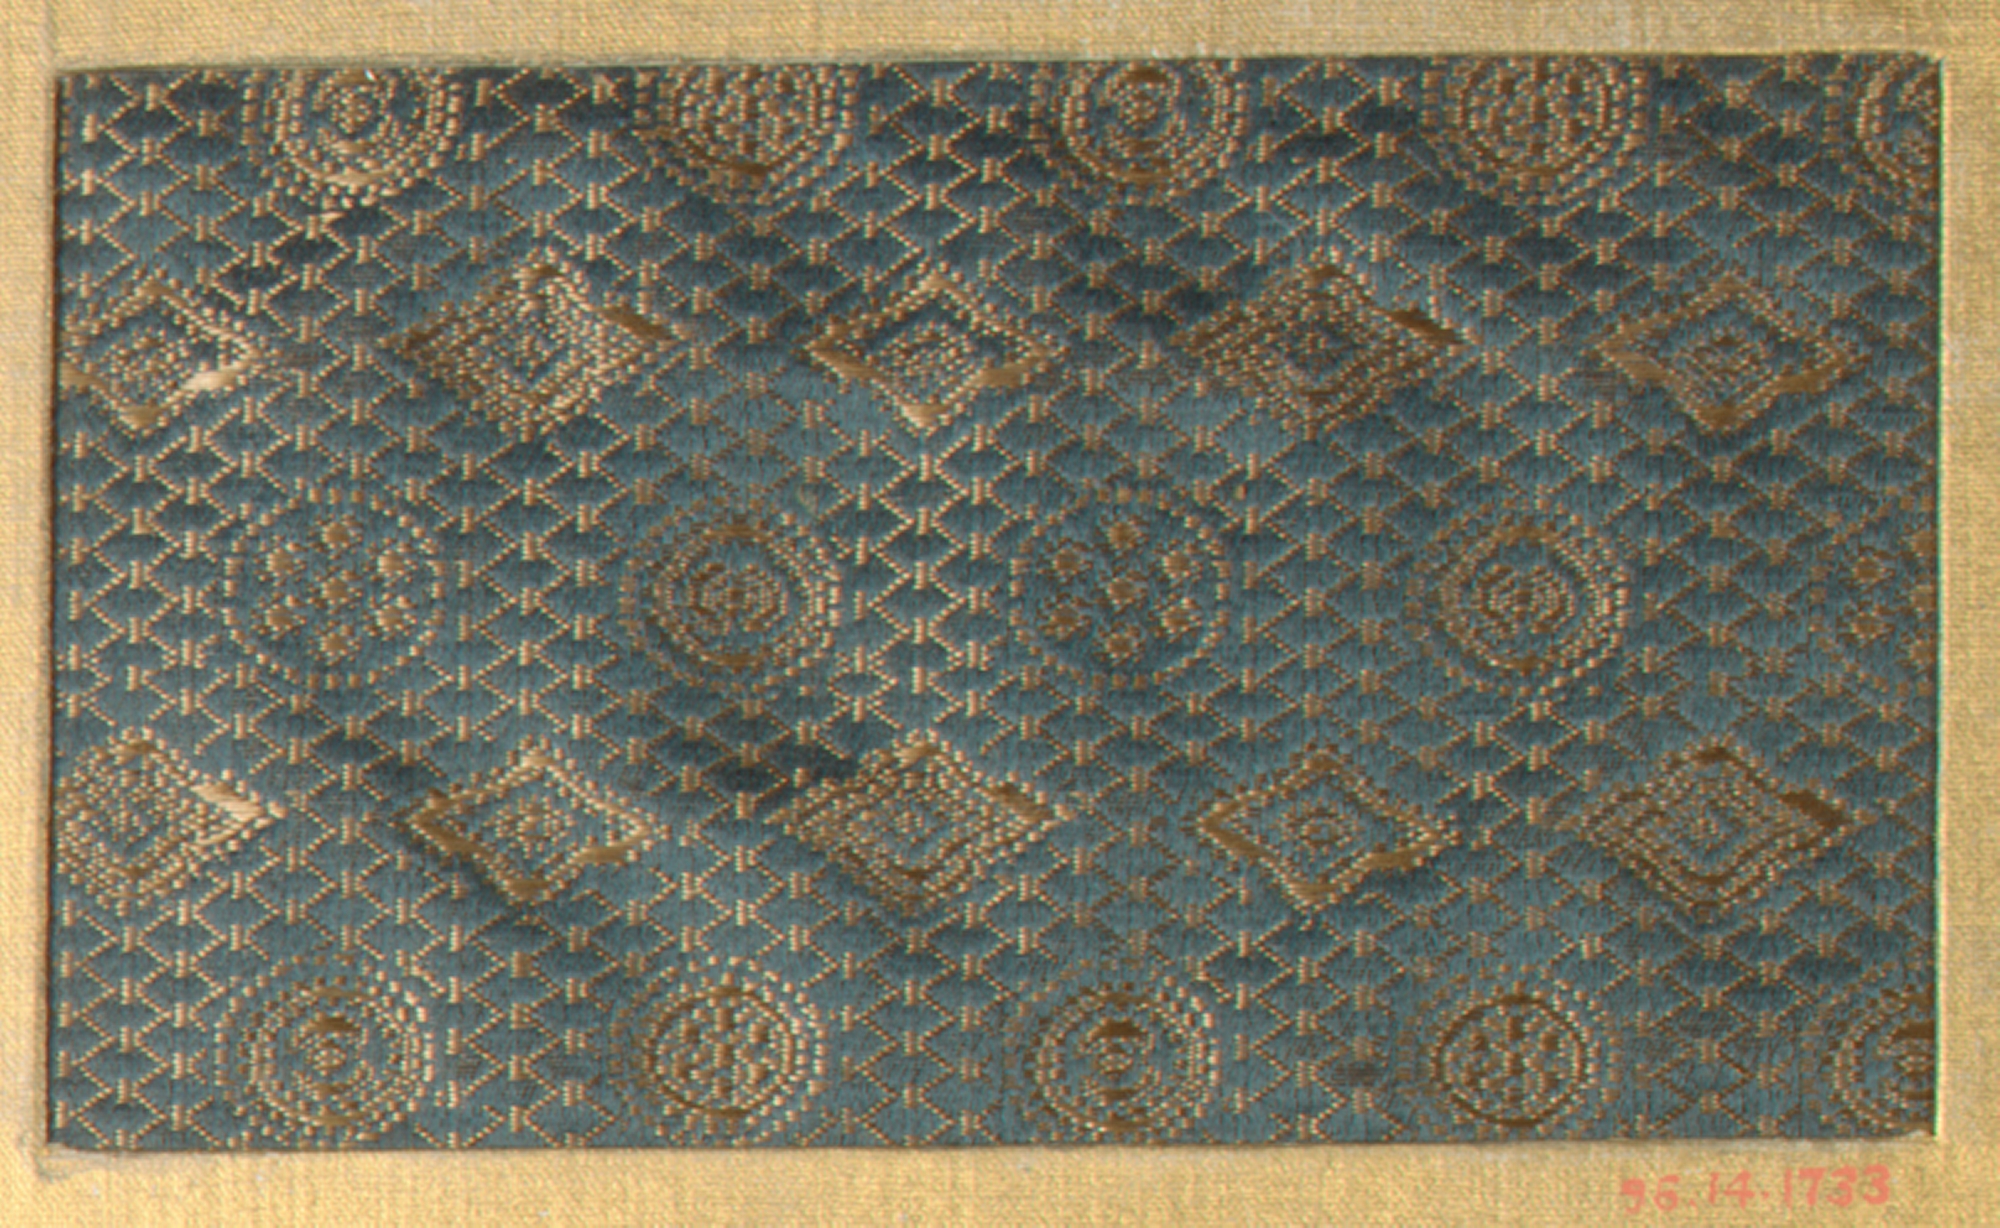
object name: piece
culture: japanese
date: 1701-1900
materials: silk